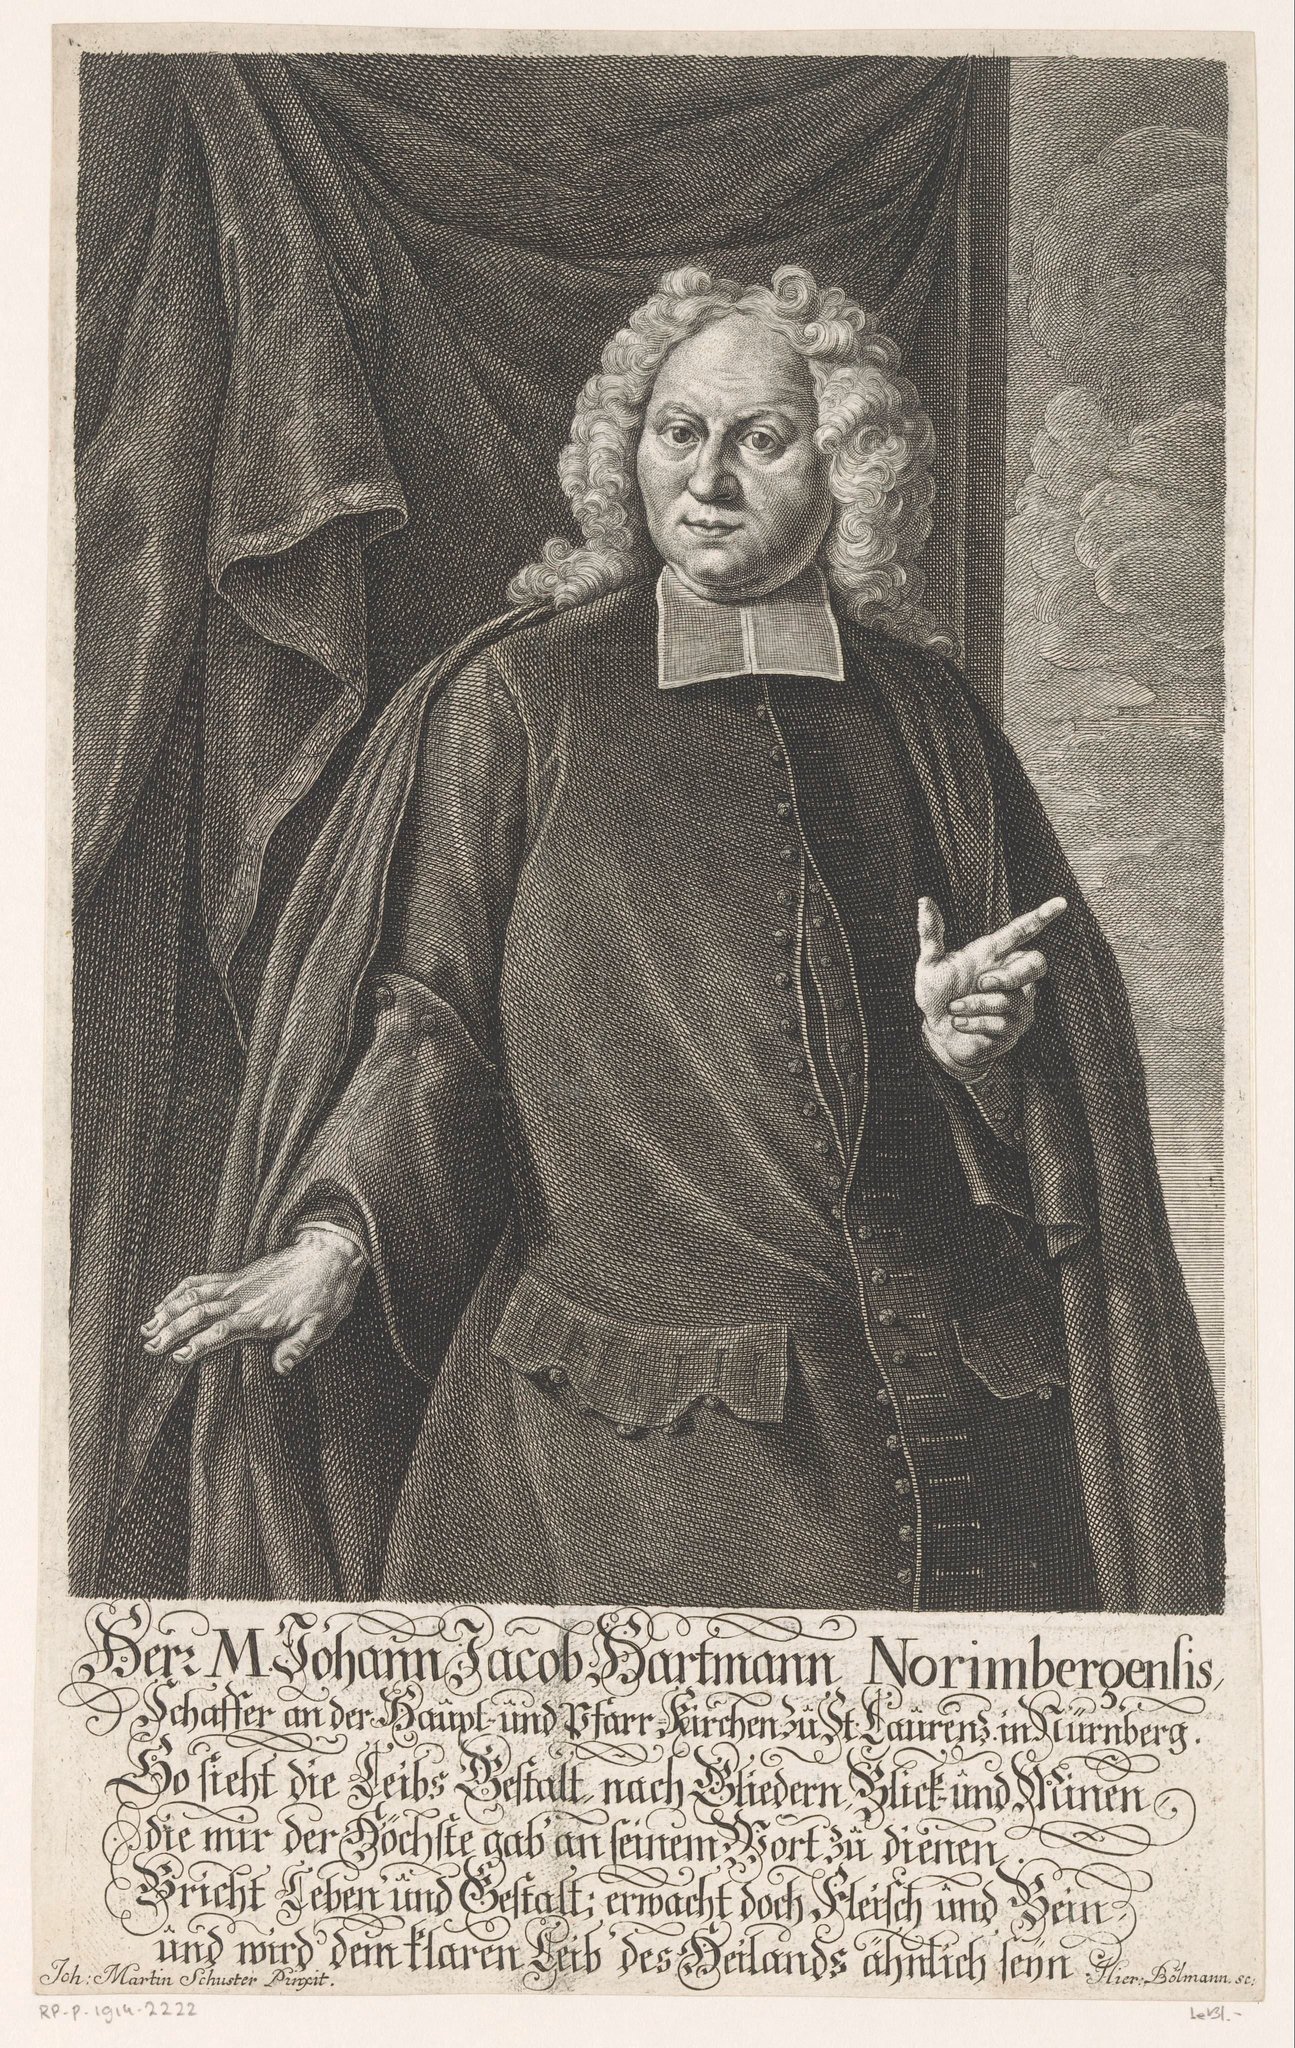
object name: print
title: Portret van Johann Jacob Hartmann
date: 1710-1730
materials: paper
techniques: engraving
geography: nuremberg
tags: johann jacob hartmann, historical persons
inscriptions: collector's mark: Lugt 2228